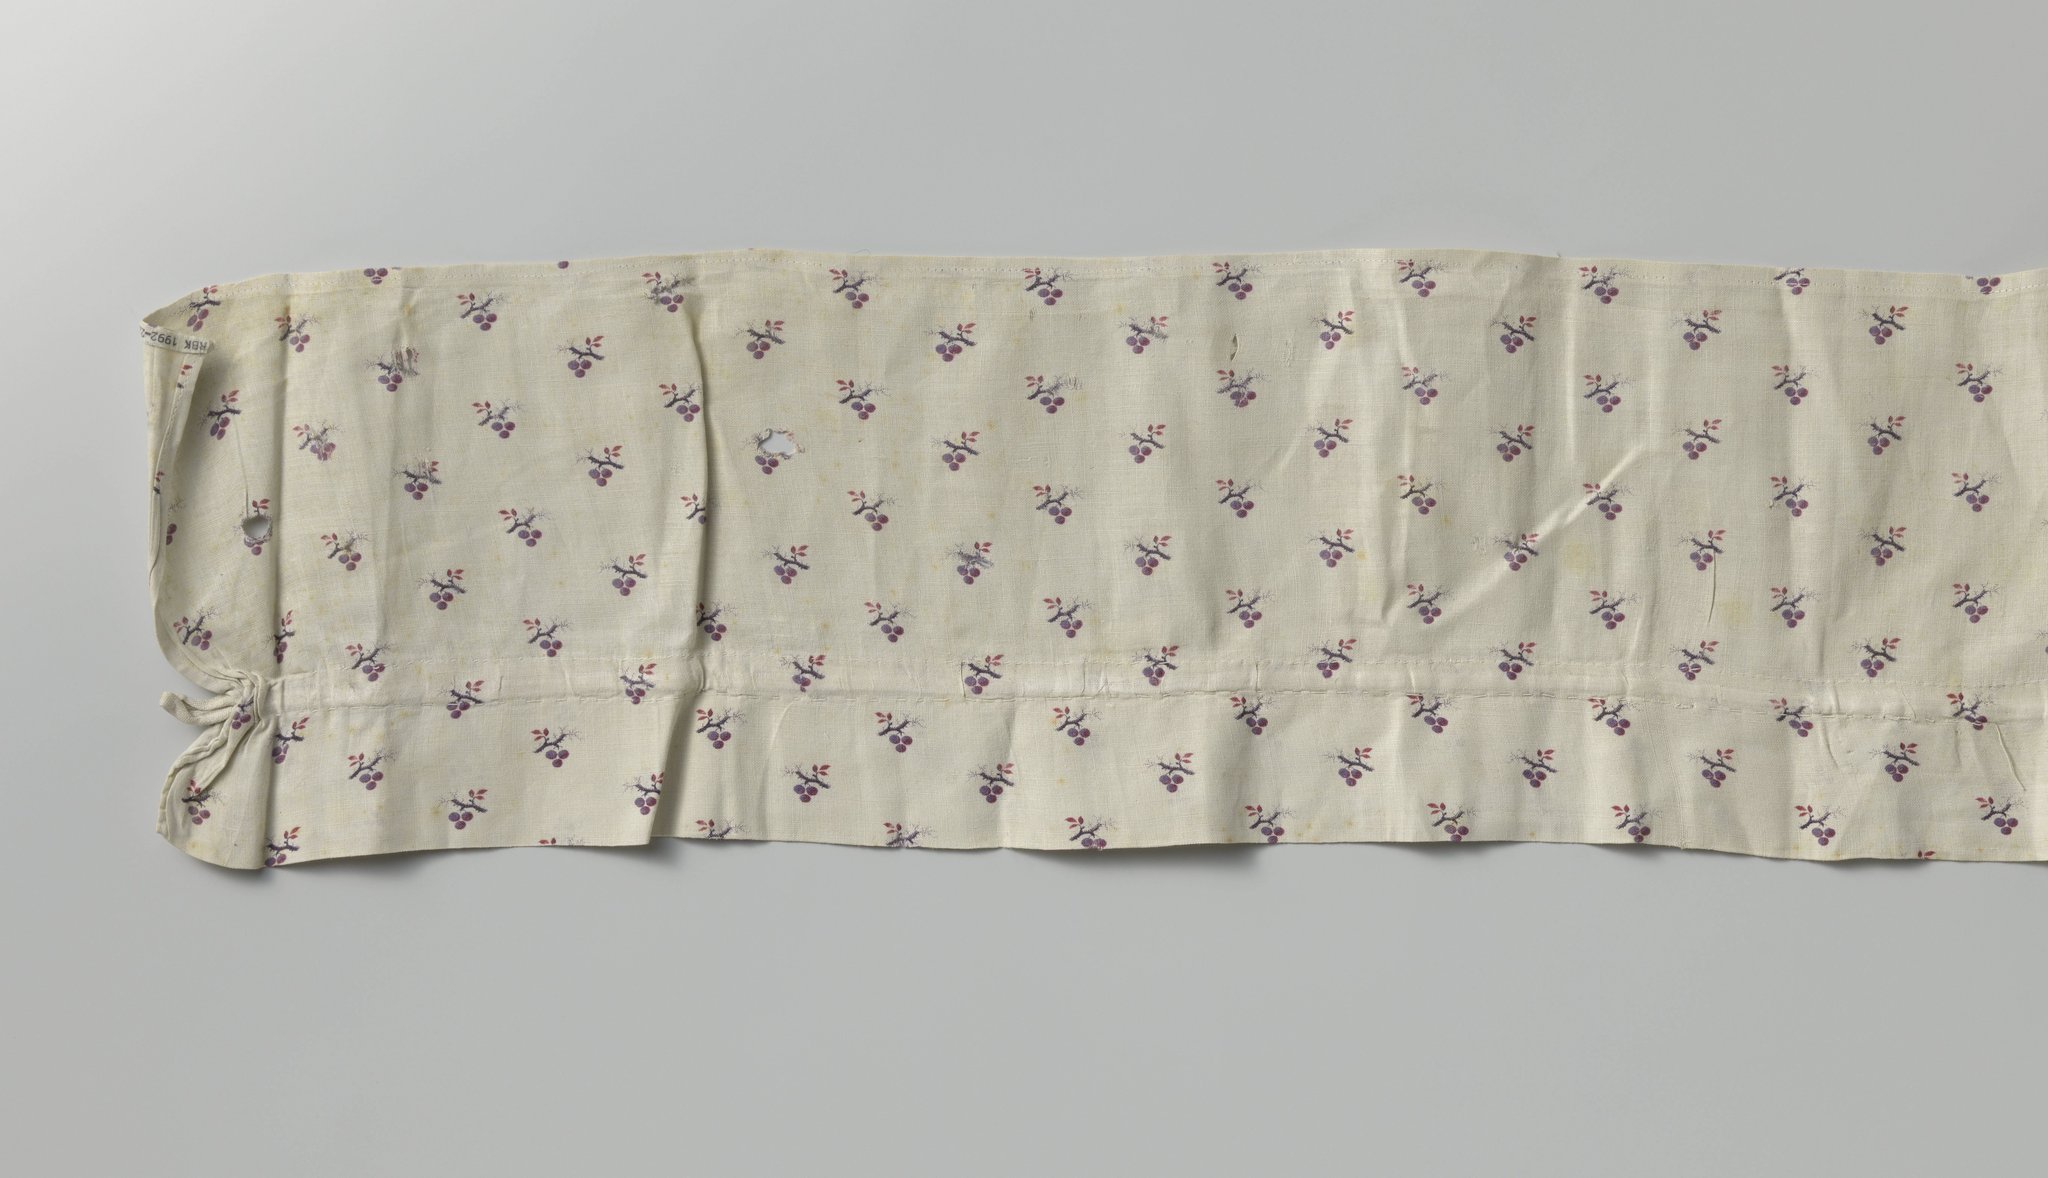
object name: curtain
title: Val van bedrukte katoen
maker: Anonymous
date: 1785-1795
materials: cotton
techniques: printing, weave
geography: england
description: Val van bedrukte katoen. Op witte katoen is een strooimotief gedrukt van een tak met bessen en bladeren.